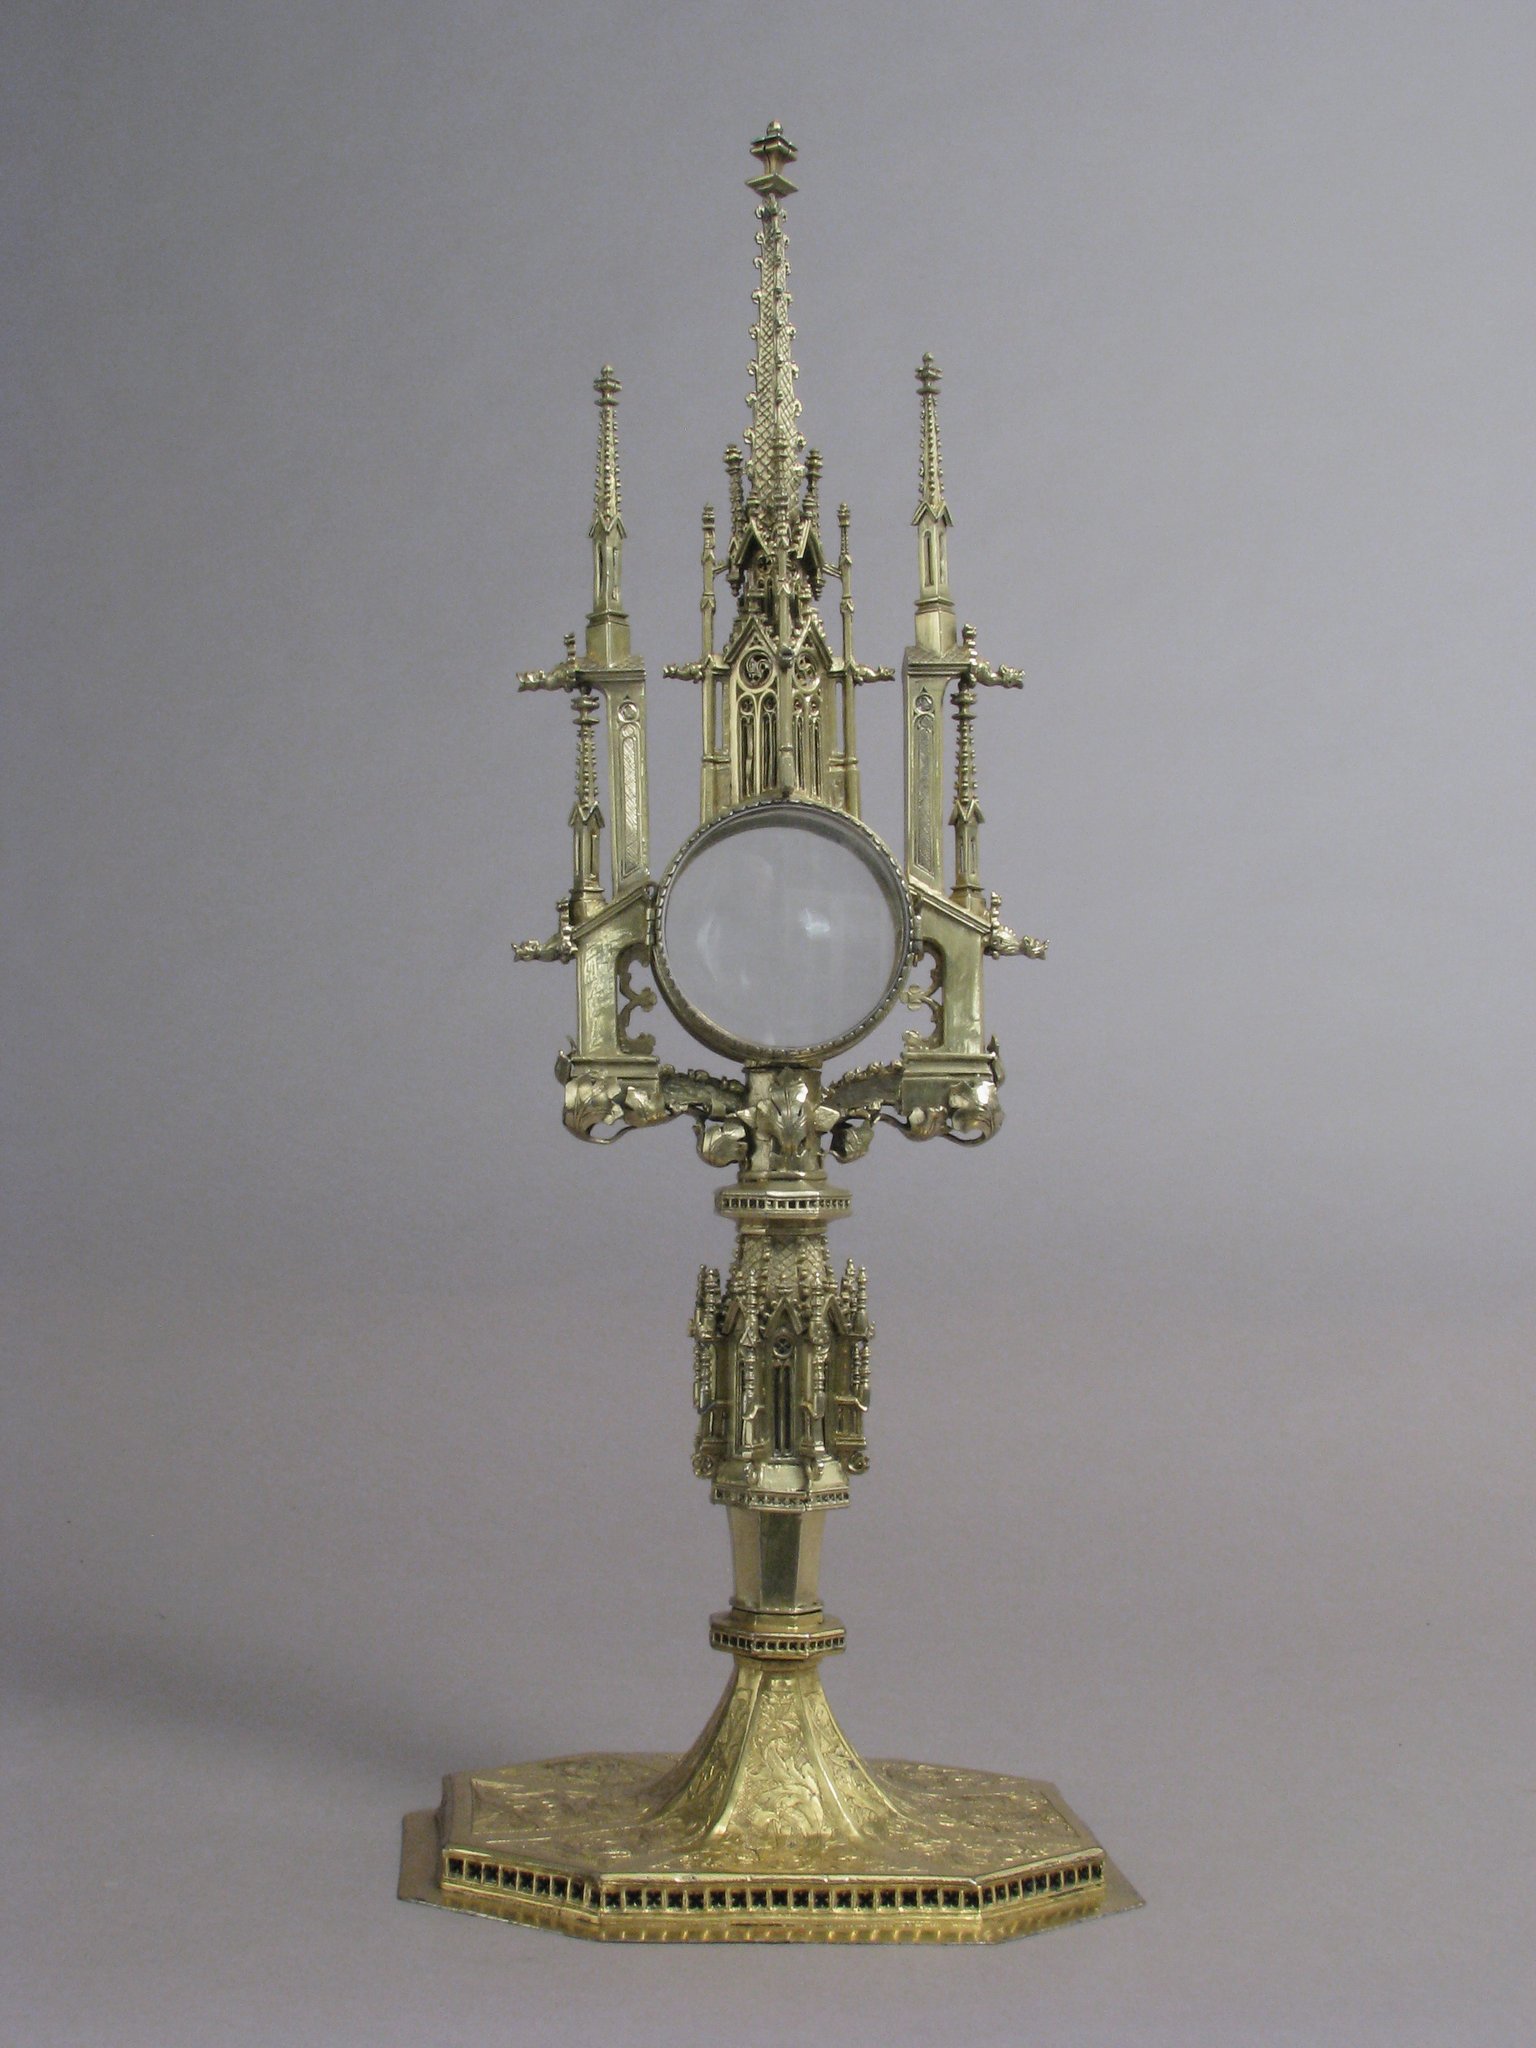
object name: reliquary monstrance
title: Reliquary, Monstrance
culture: german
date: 1401-1500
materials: gilt copper, glass, silver gilt